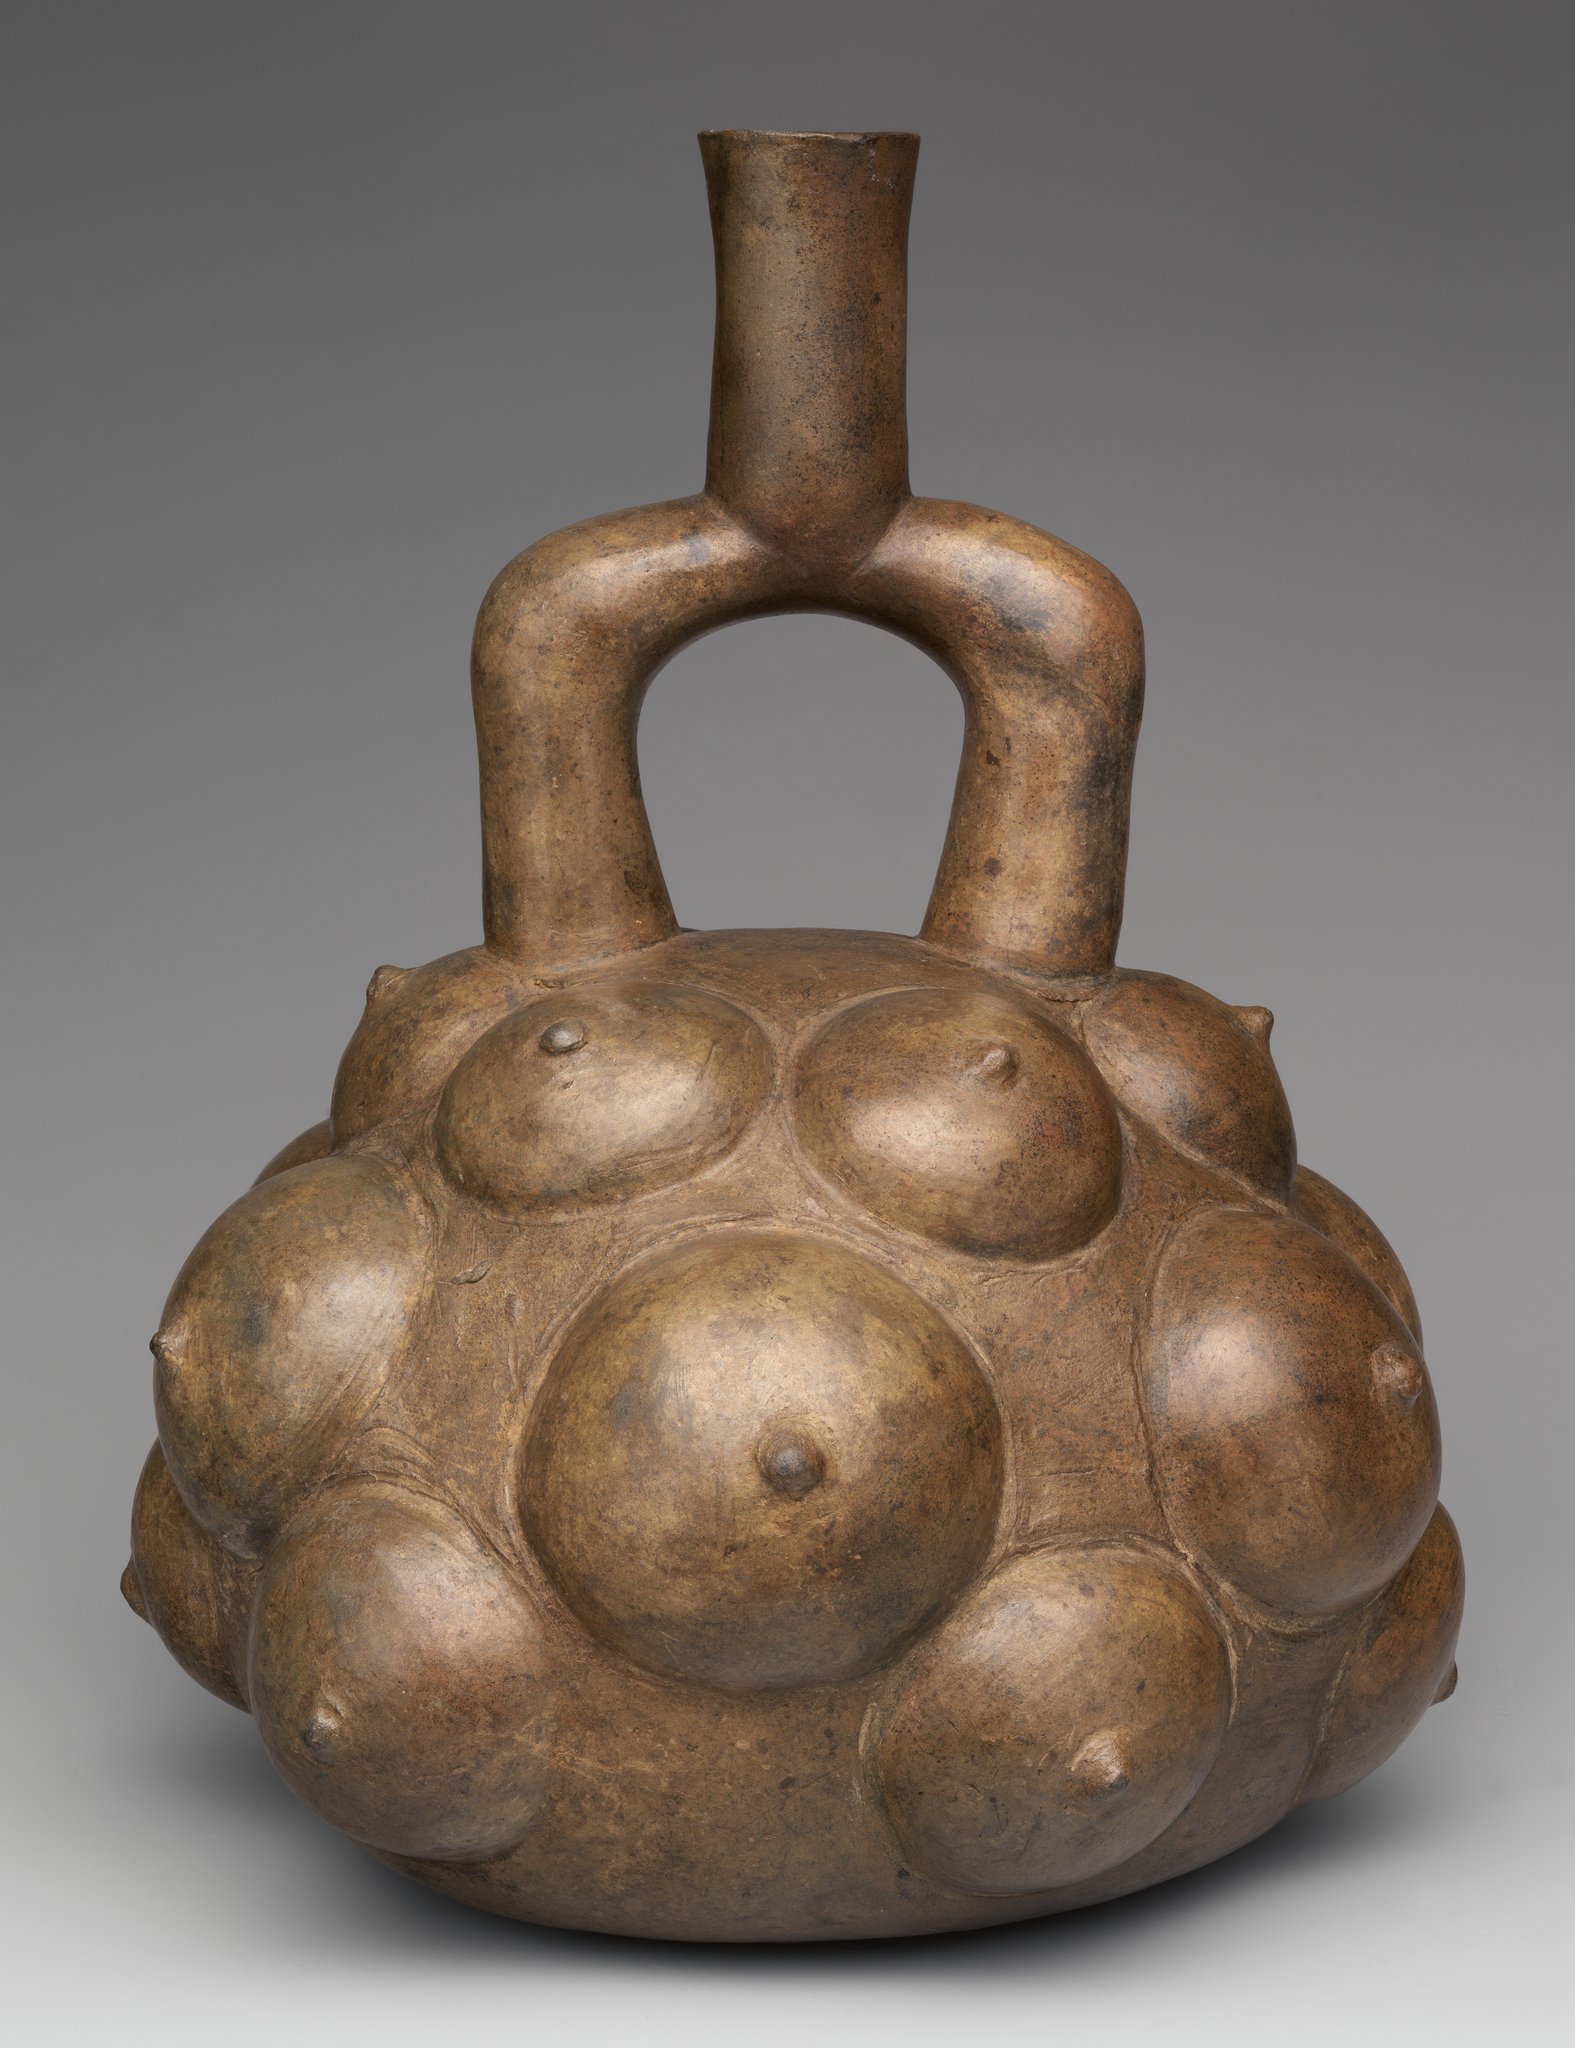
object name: bottle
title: Stirrup-spout bottle with fruits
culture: cupisnique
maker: cupisnique artist(s)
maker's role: artist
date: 1200-800 BCE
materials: ceramic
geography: peru